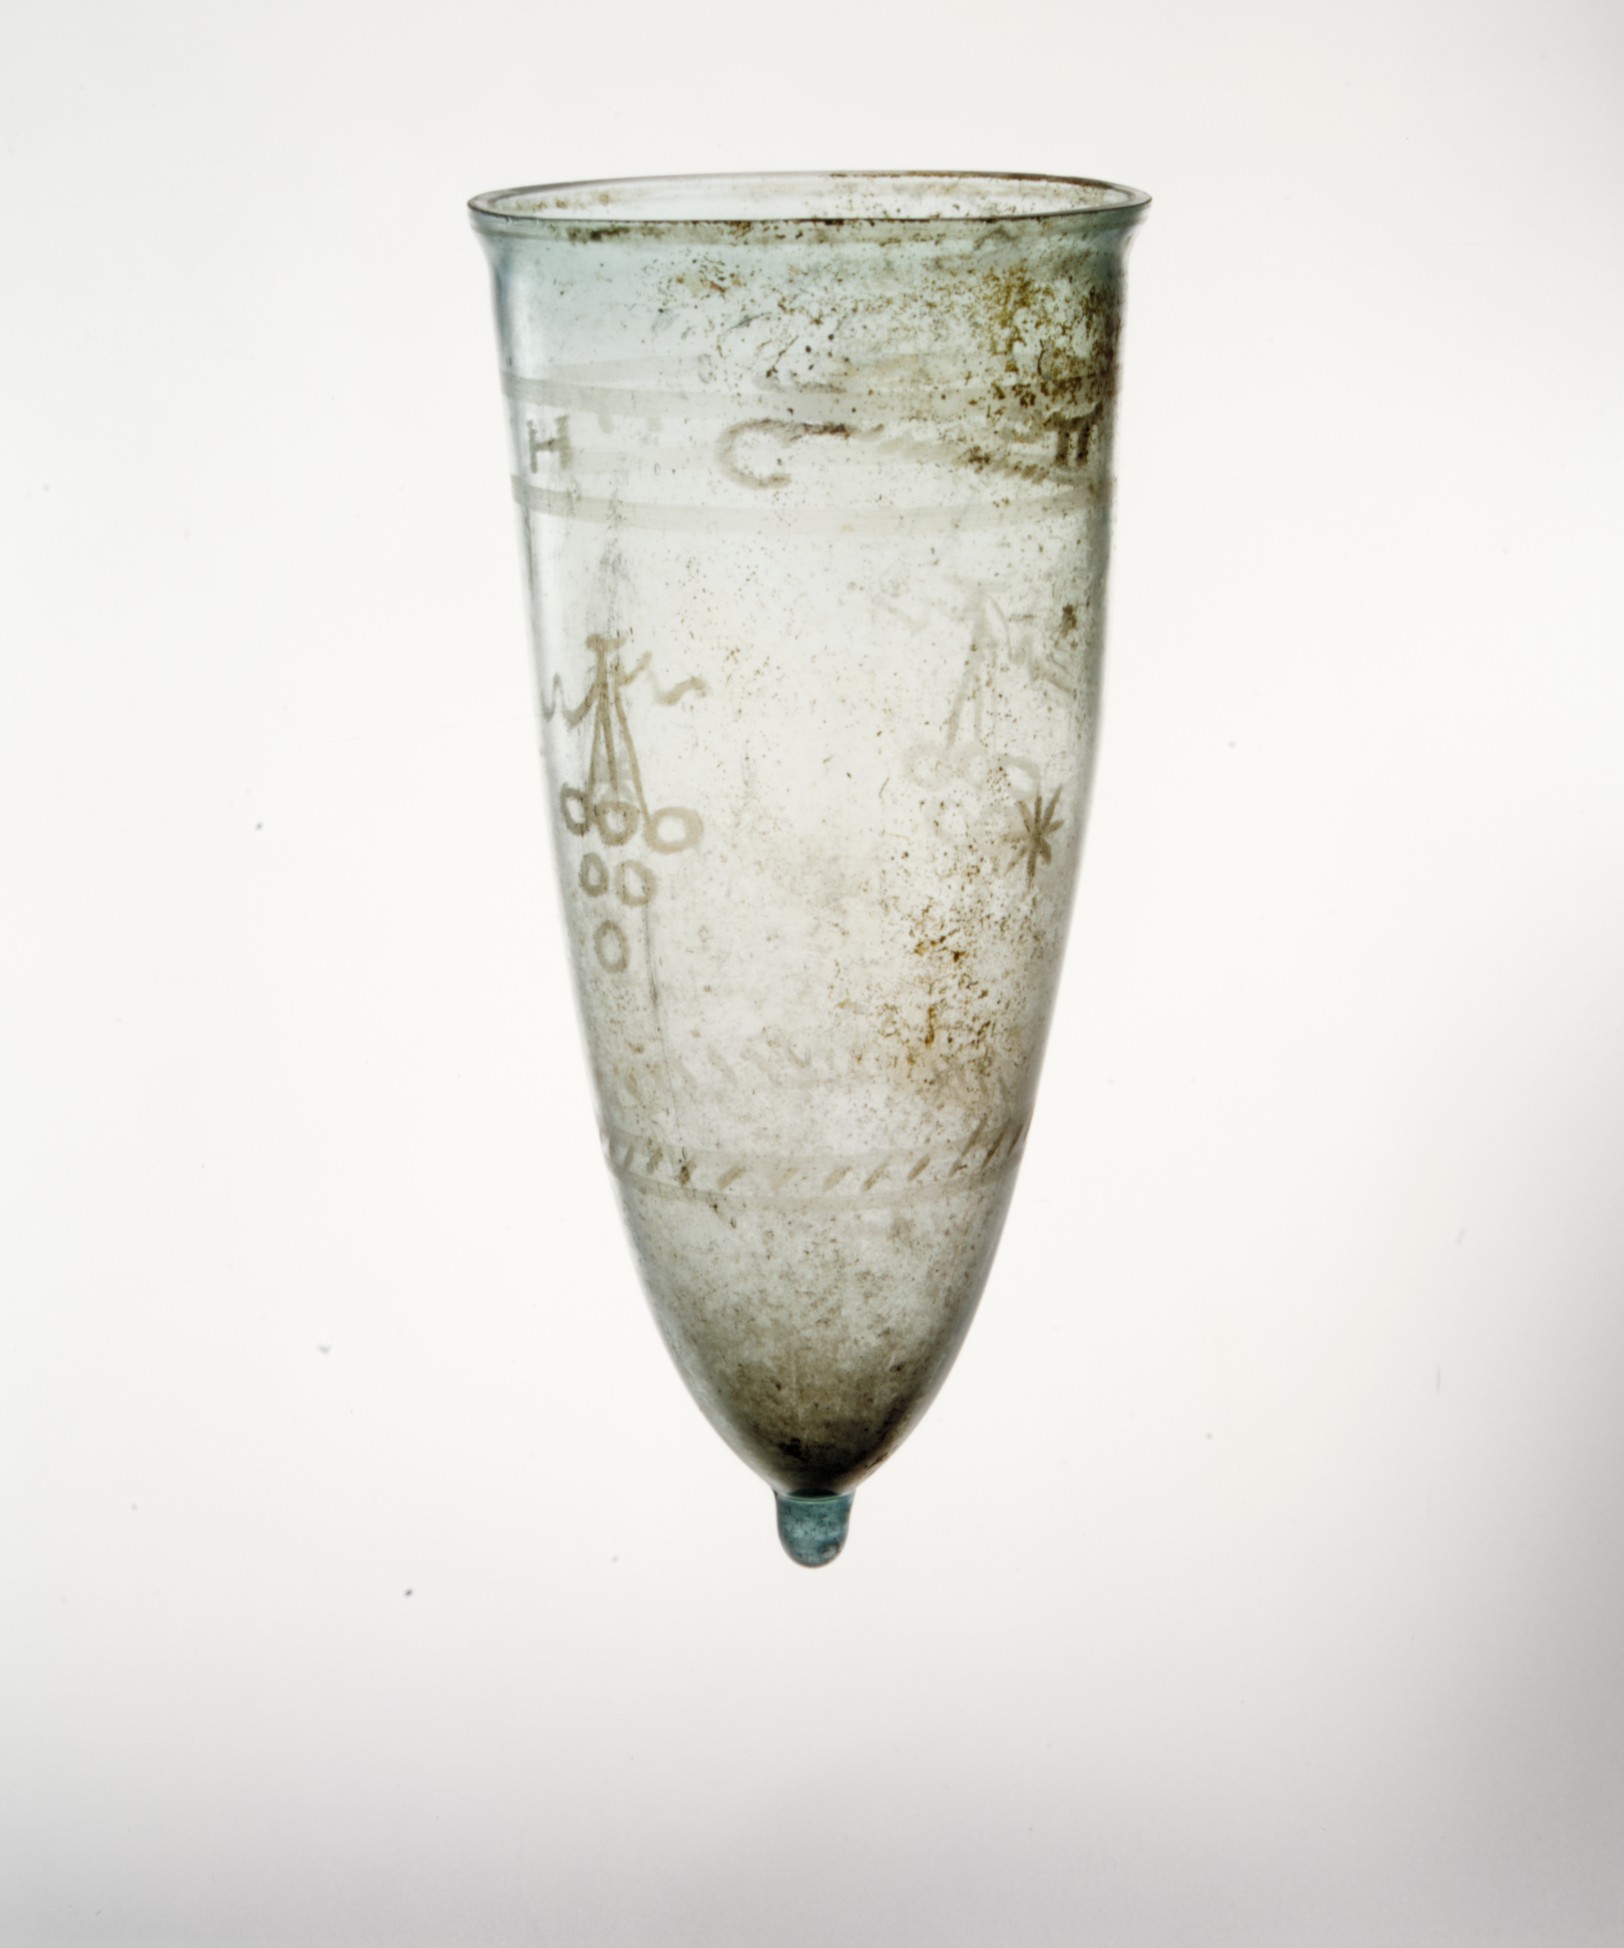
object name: beaker, inscribed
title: Glass beaker with cut decoration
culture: roman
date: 301-433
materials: glass